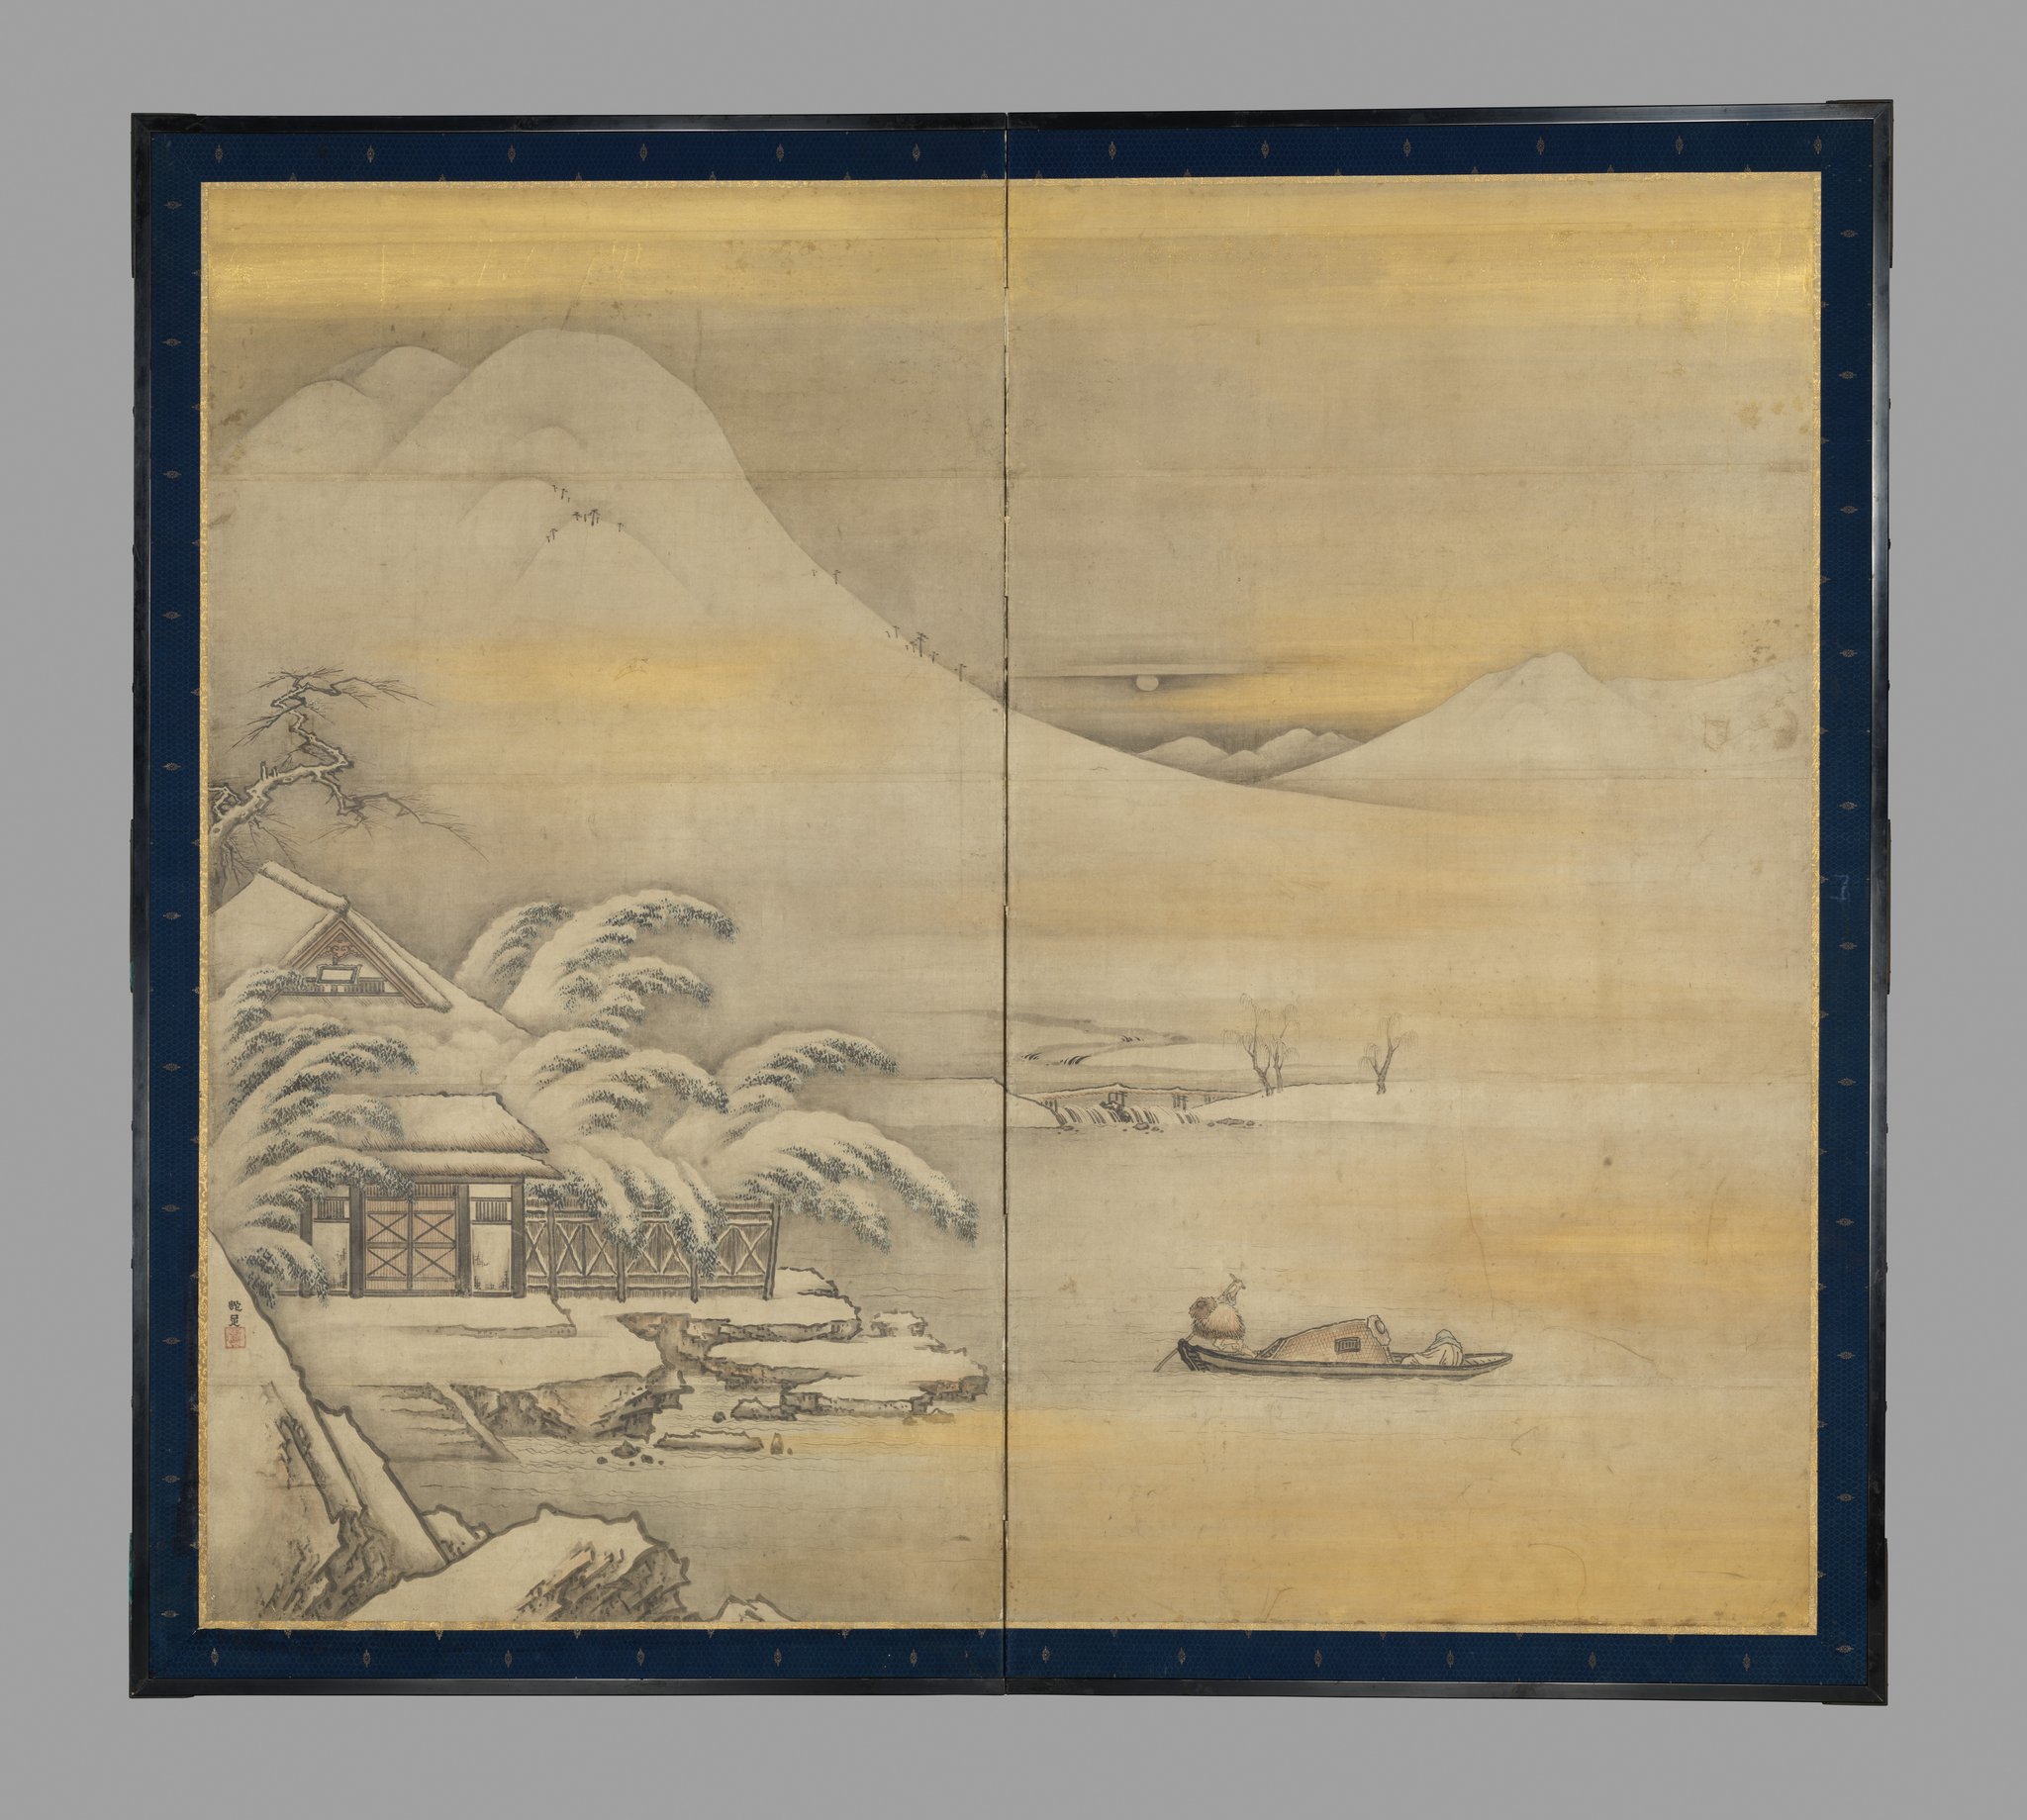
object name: screen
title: Wang Ziyou Visiting Dai Andao on a Snowy Evening (Ō Shiyū hō Tai Andō zu)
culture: japanese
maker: kano sansetsu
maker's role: artist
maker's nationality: japanese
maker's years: 1590-1651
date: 1634-1666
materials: gold, ink, panel, paper